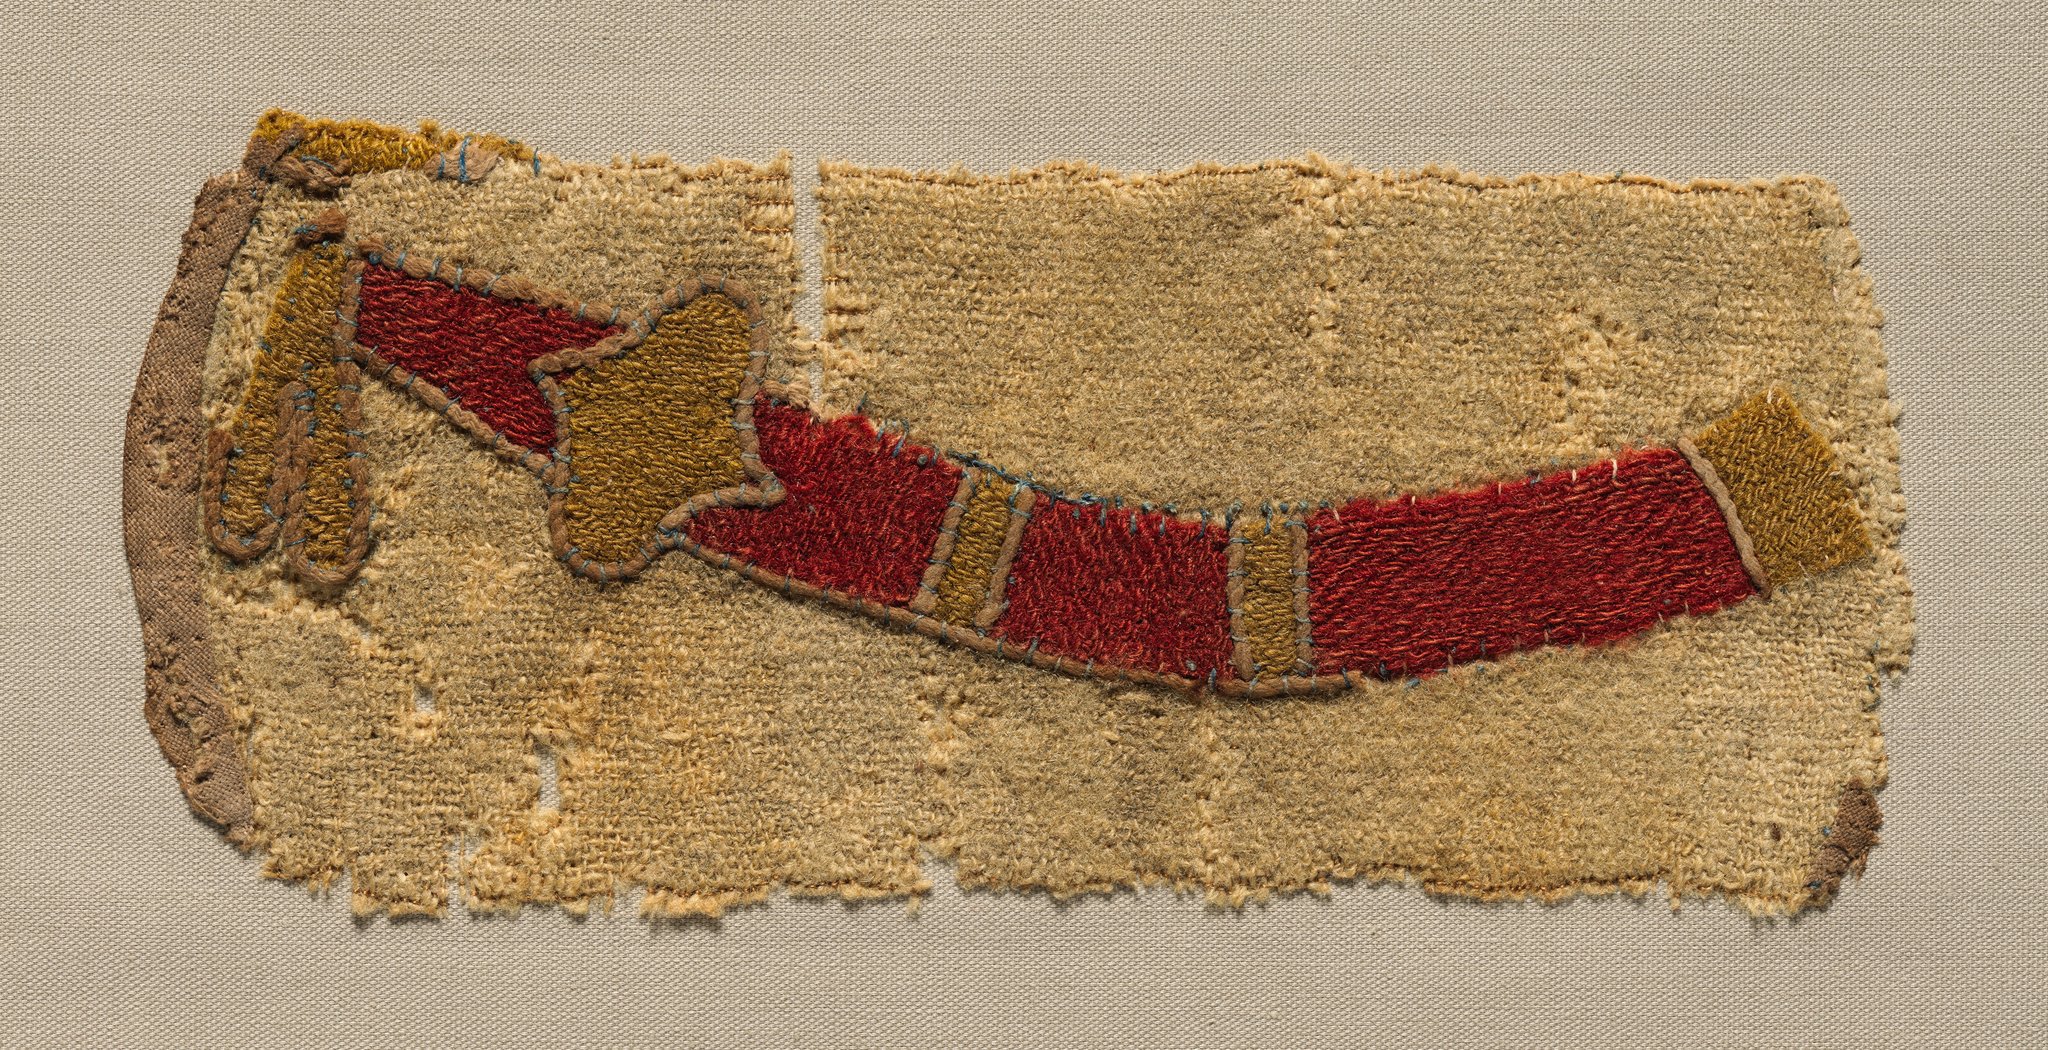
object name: textile fragment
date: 1301-1400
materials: wool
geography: egypt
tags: swords